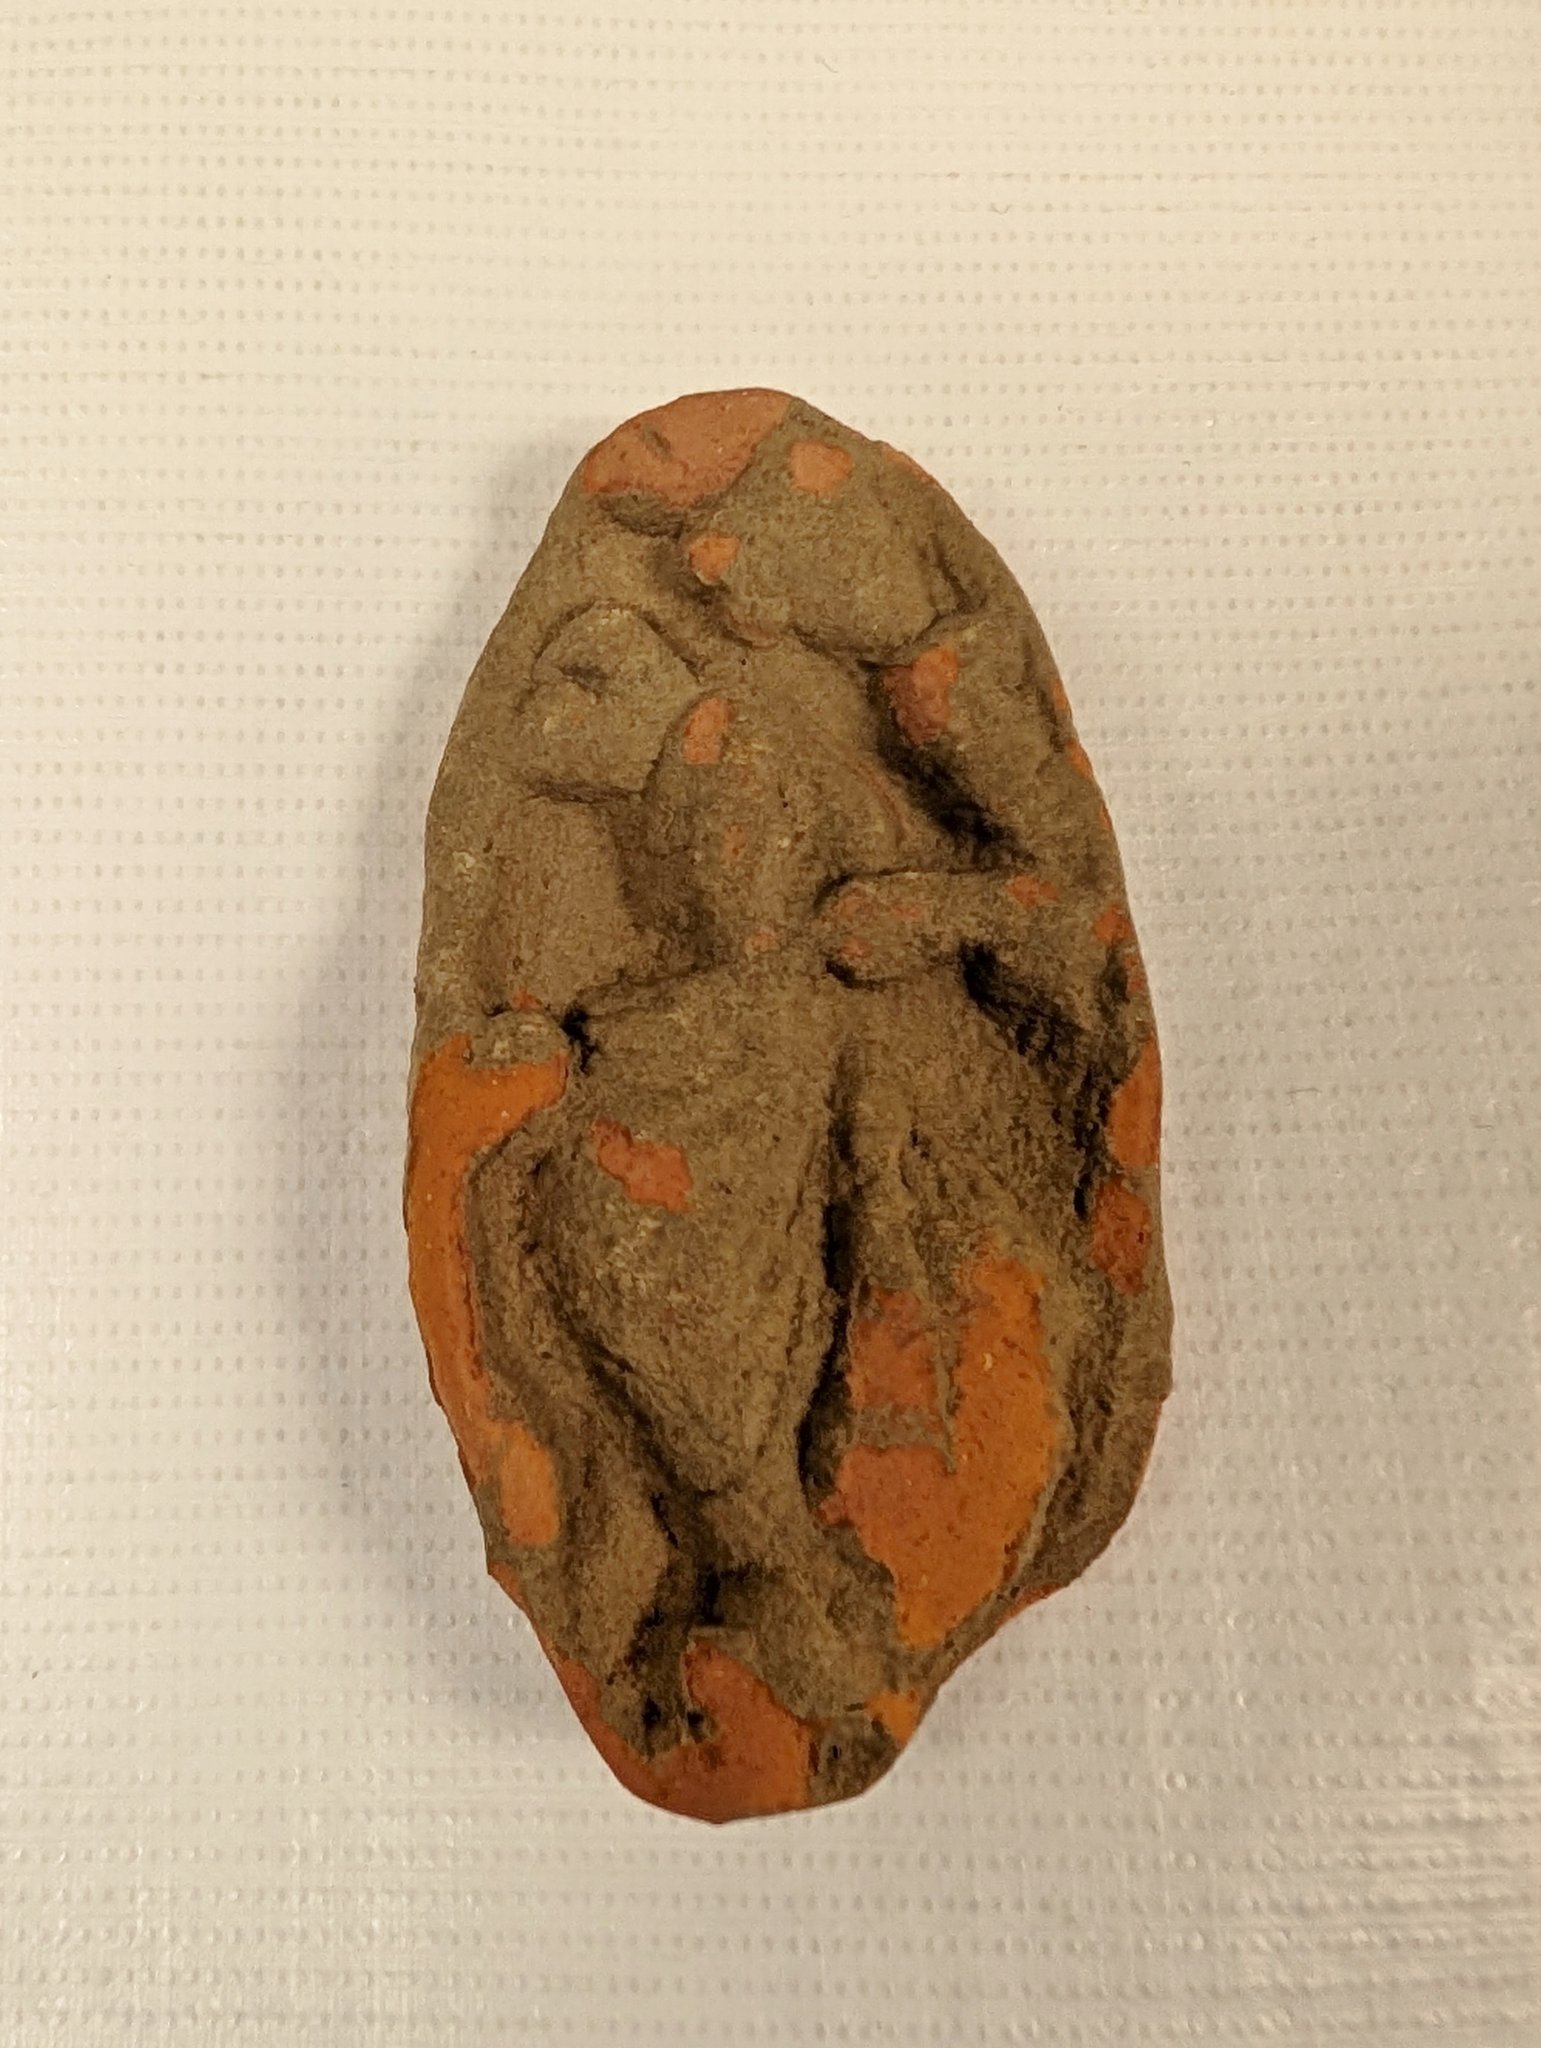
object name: plaque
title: Plaque in the Form of a Female Figure (Study Collection)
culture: pakistani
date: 101-300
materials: terracotta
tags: gandhara